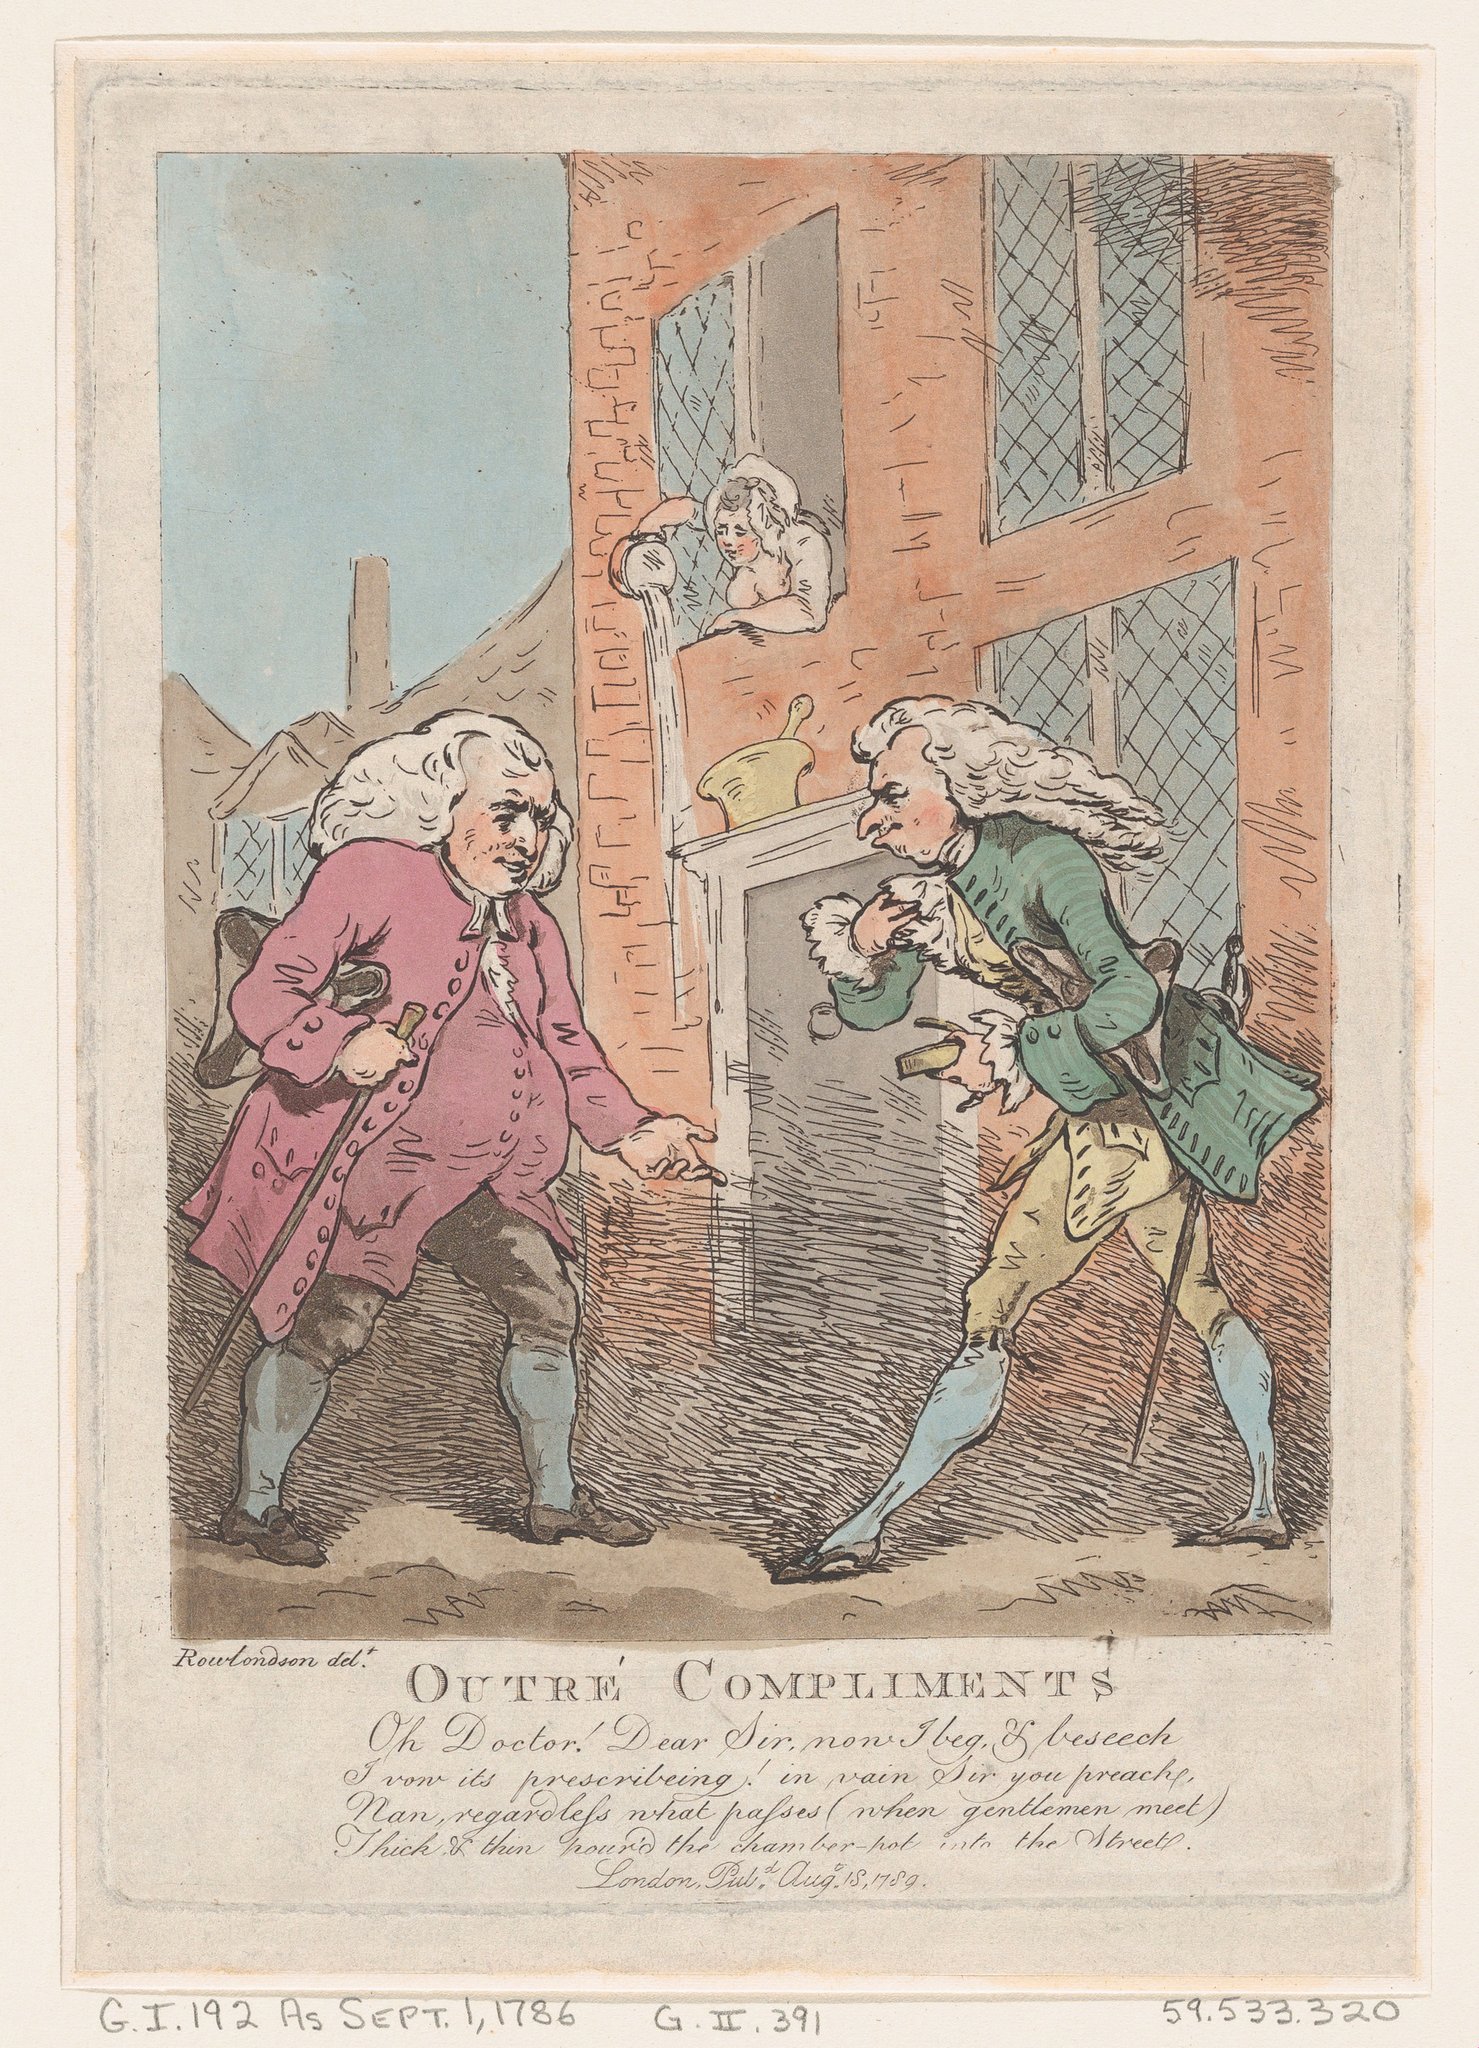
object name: print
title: Outré Compliments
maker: thomas rowlandson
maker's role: artist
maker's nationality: british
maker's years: 1757-1827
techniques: etching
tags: satire,men,women